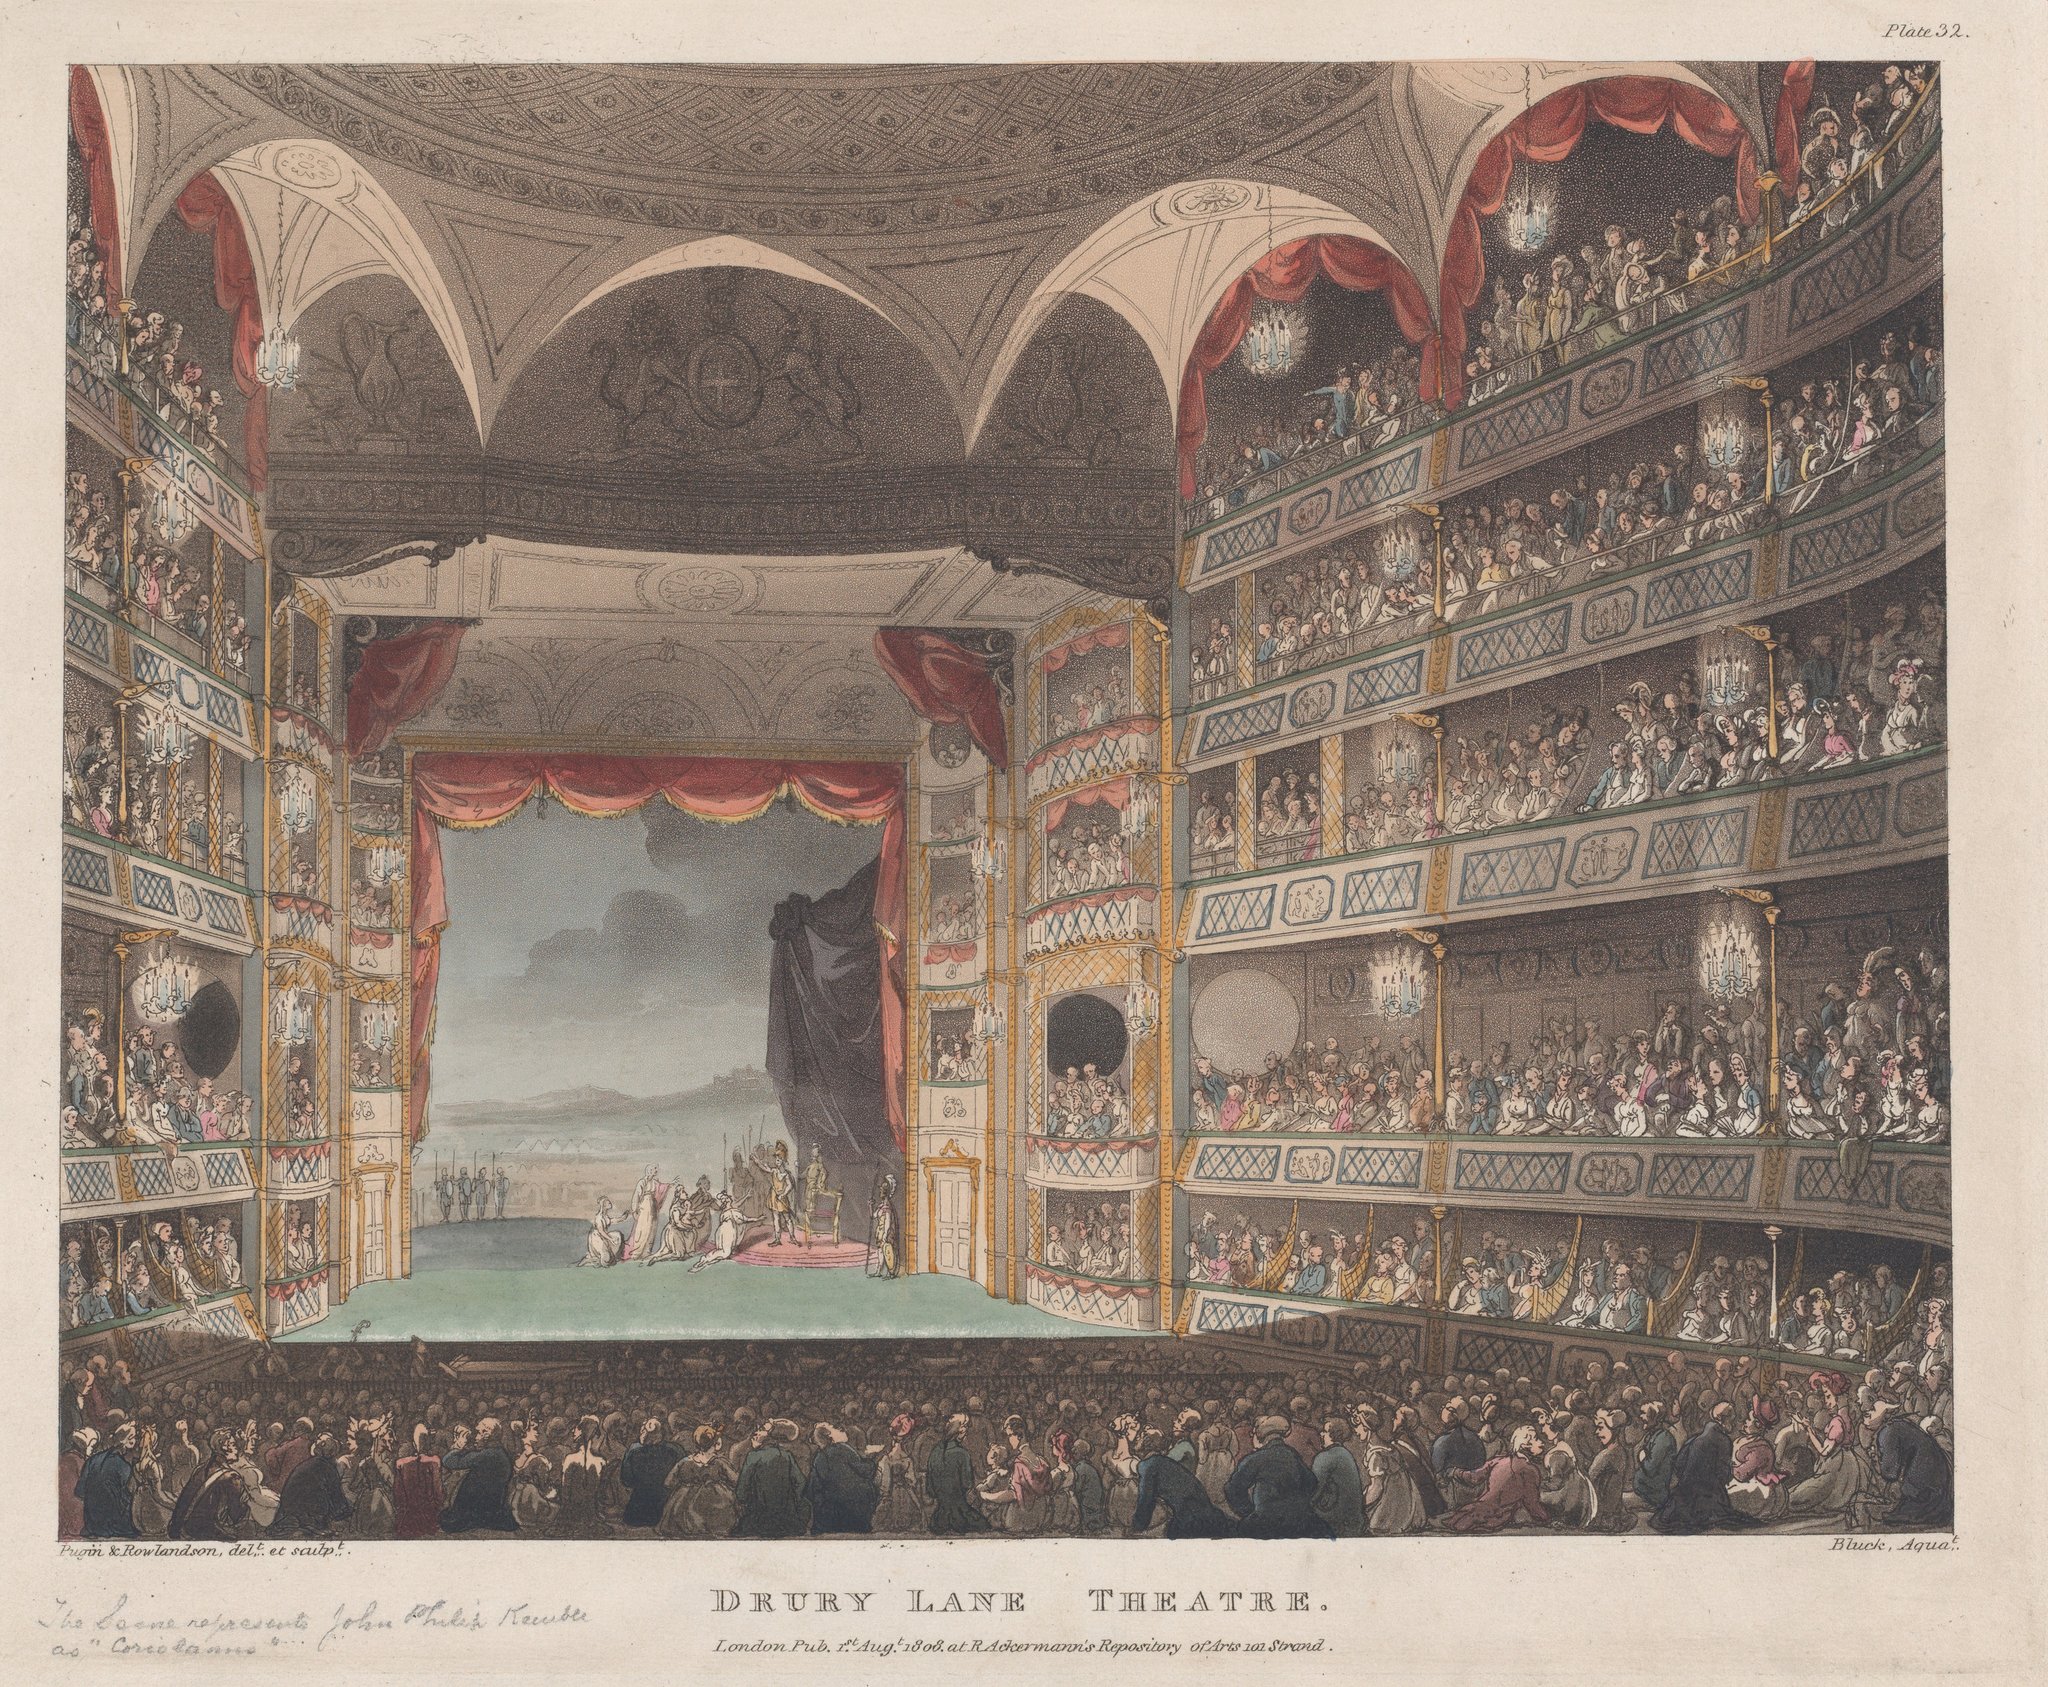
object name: print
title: Drury Lane Theatre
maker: thomas rowlandson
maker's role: artist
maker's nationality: british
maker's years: 1757-1827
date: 1808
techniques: aquatint, etching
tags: theatre,interiors,spectators,london